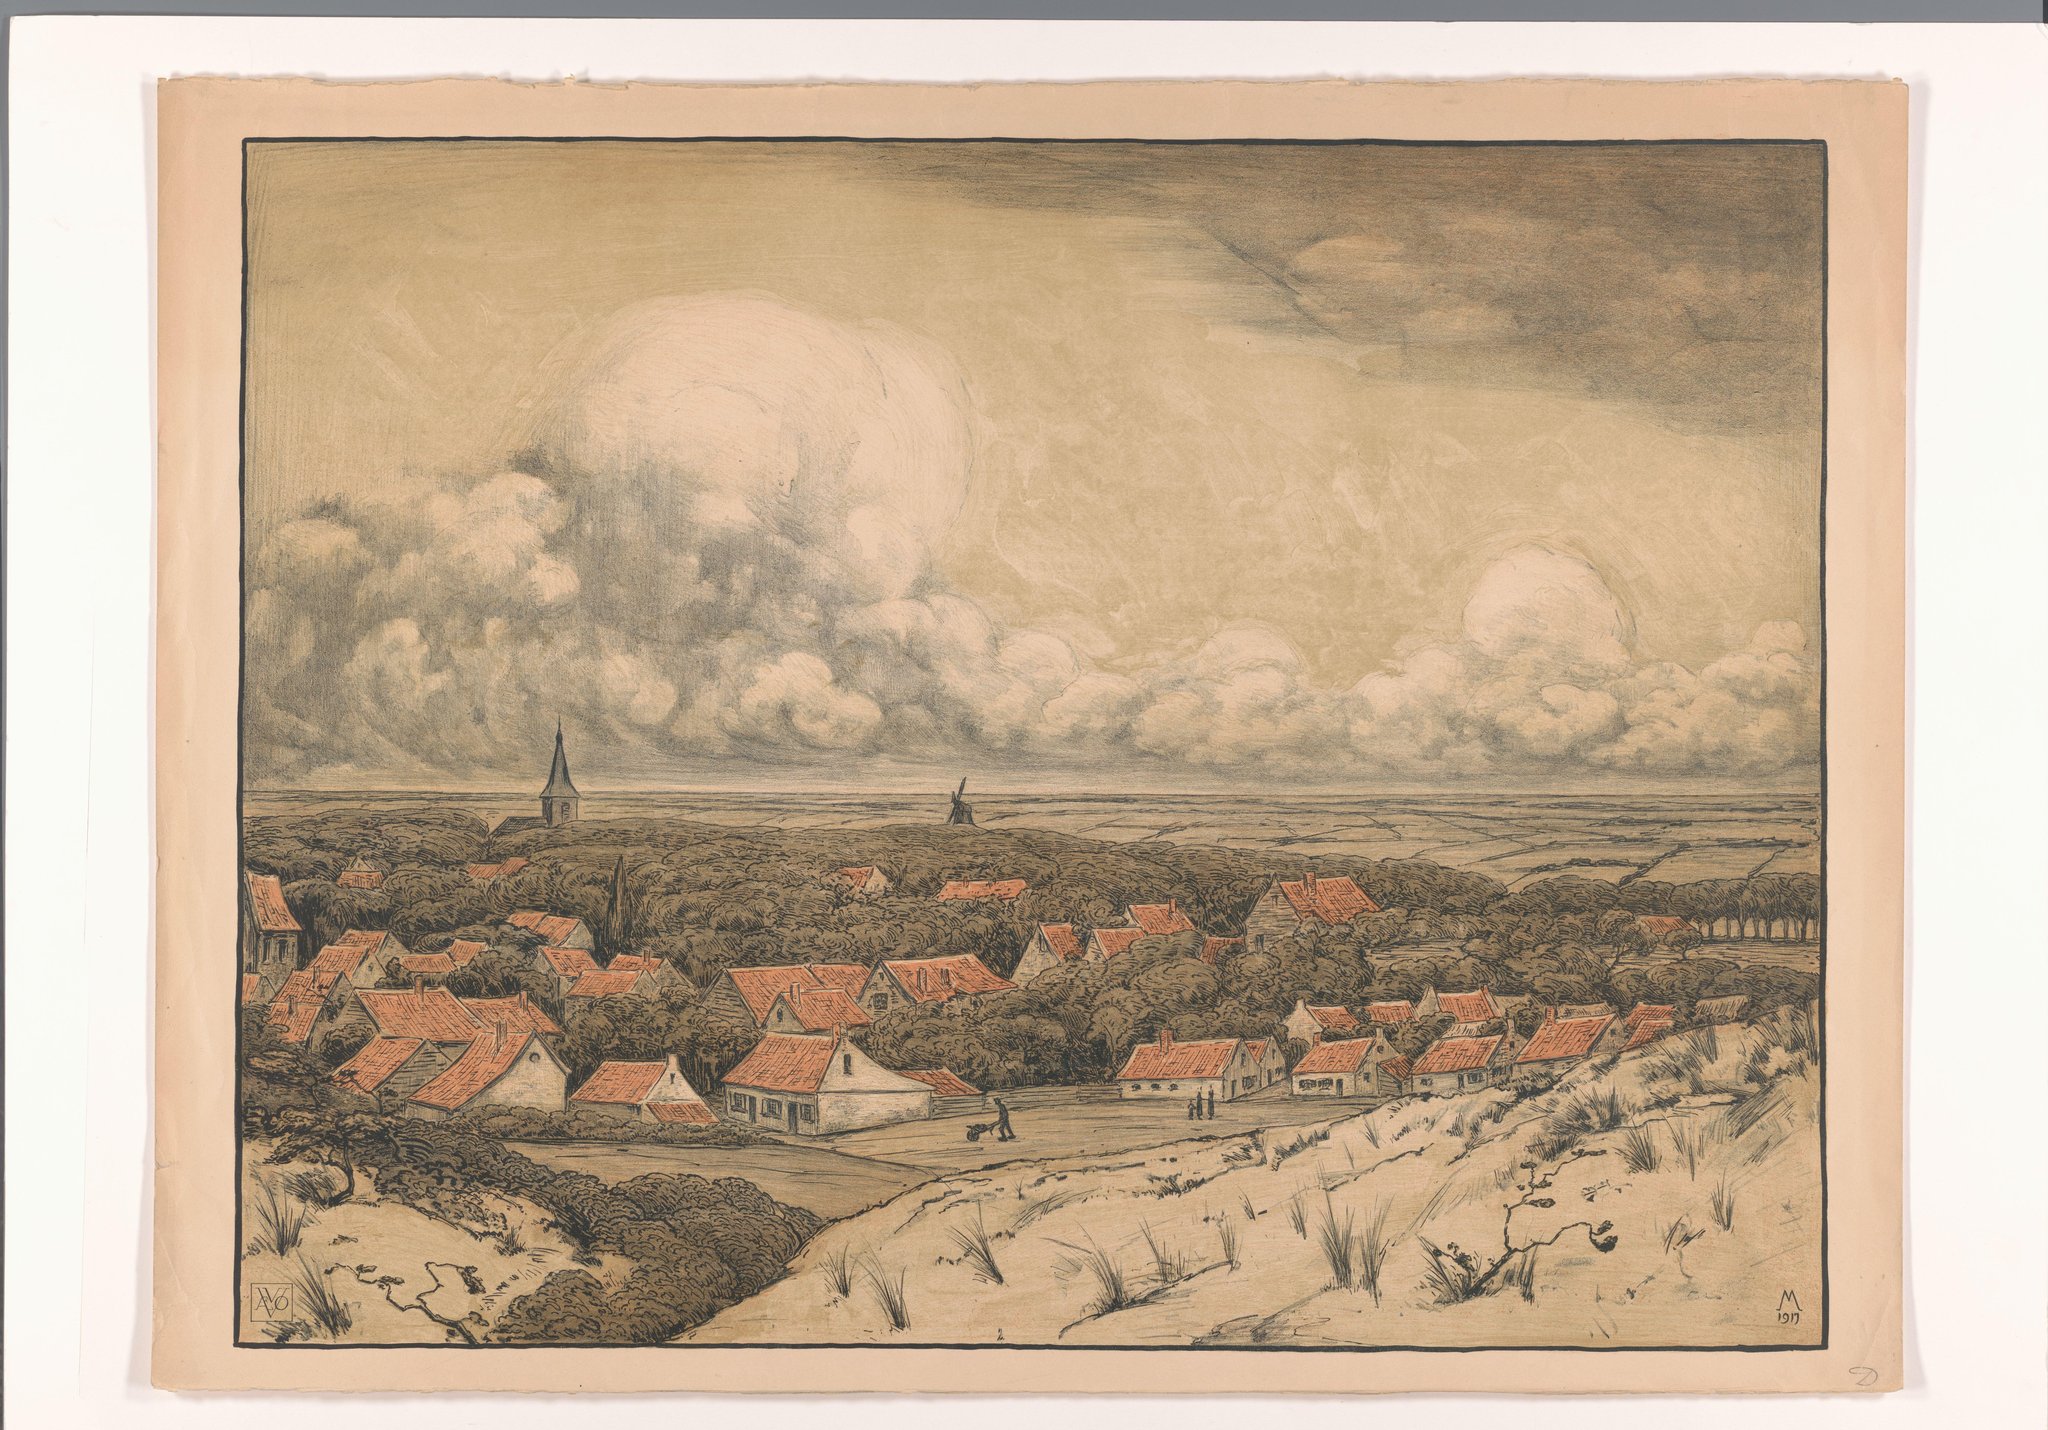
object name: print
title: Gezicht op Walcheren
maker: monogrammist m (20e eeuw)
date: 1917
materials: paper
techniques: lithograph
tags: polder, reclaimed land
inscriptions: collector's mark: Lugt 2233